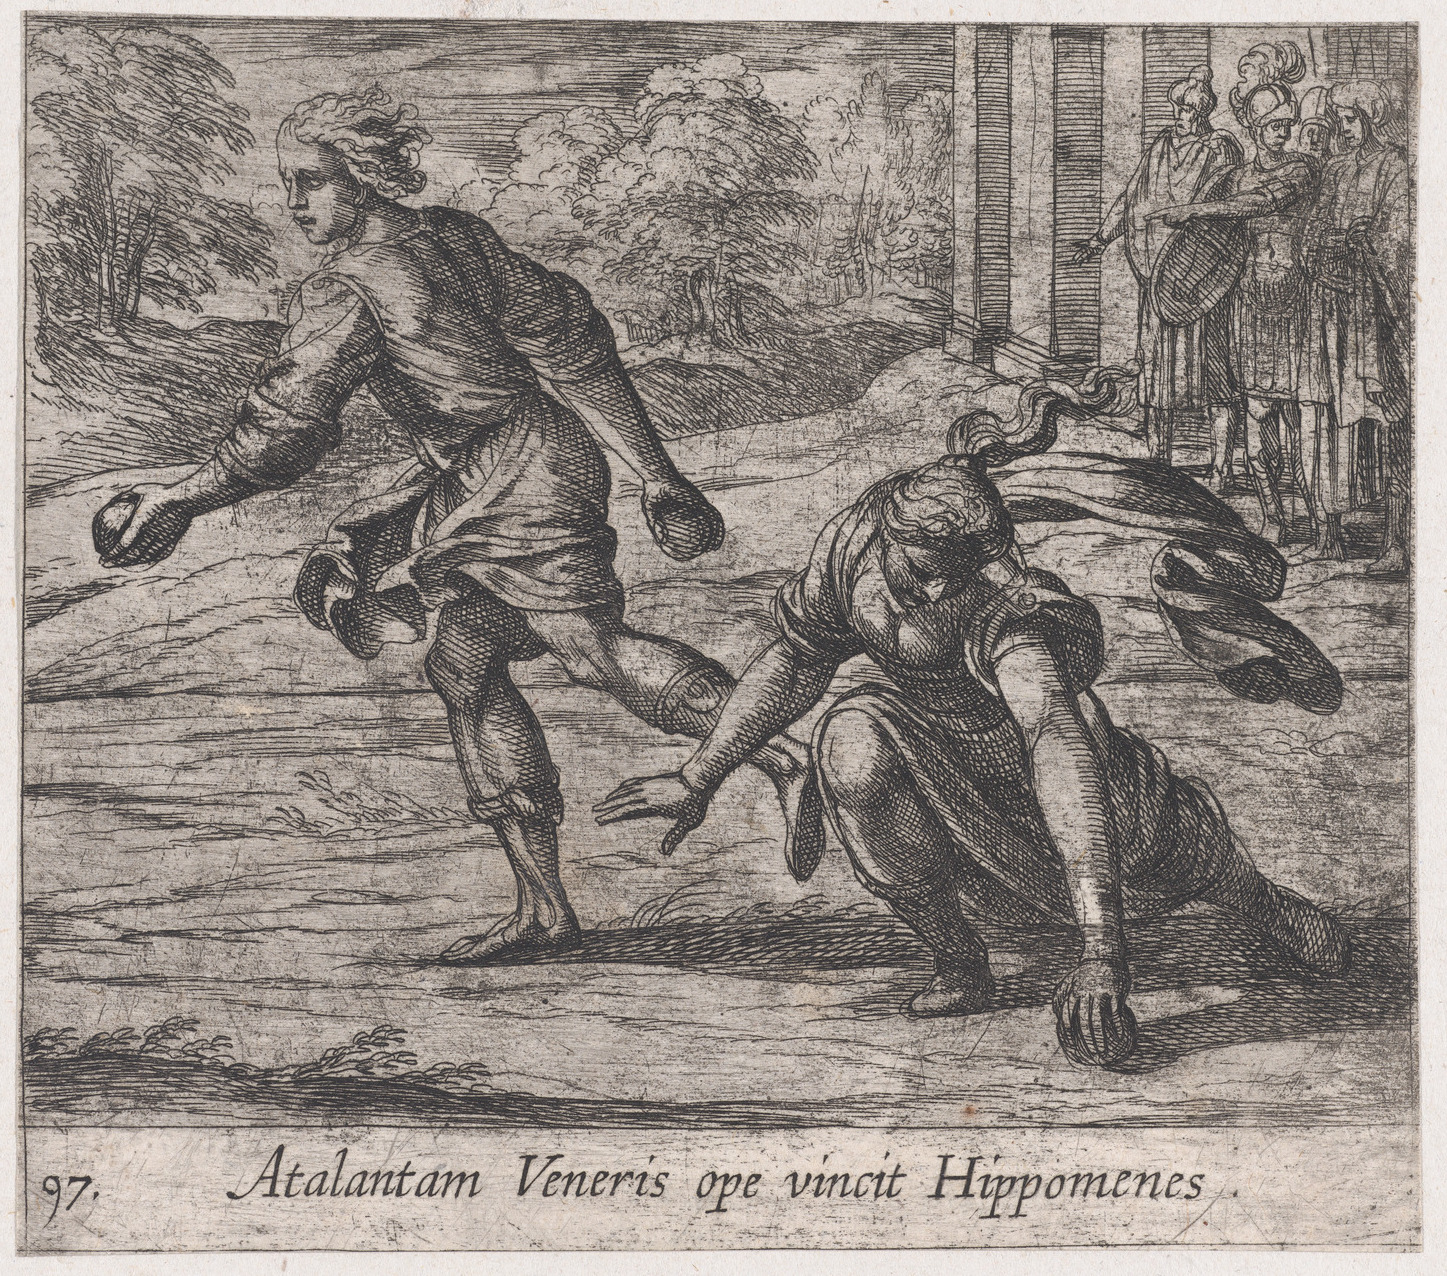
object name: print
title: Plate 97: Hippomenes Winning the Race with Atalanta (Atalantam Veneris ope vincit Hippomenes), from Ovid's 'Metamorphoses'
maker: antonio tempesta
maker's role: artist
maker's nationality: italian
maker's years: 1555-1630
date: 1606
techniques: etching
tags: men,women